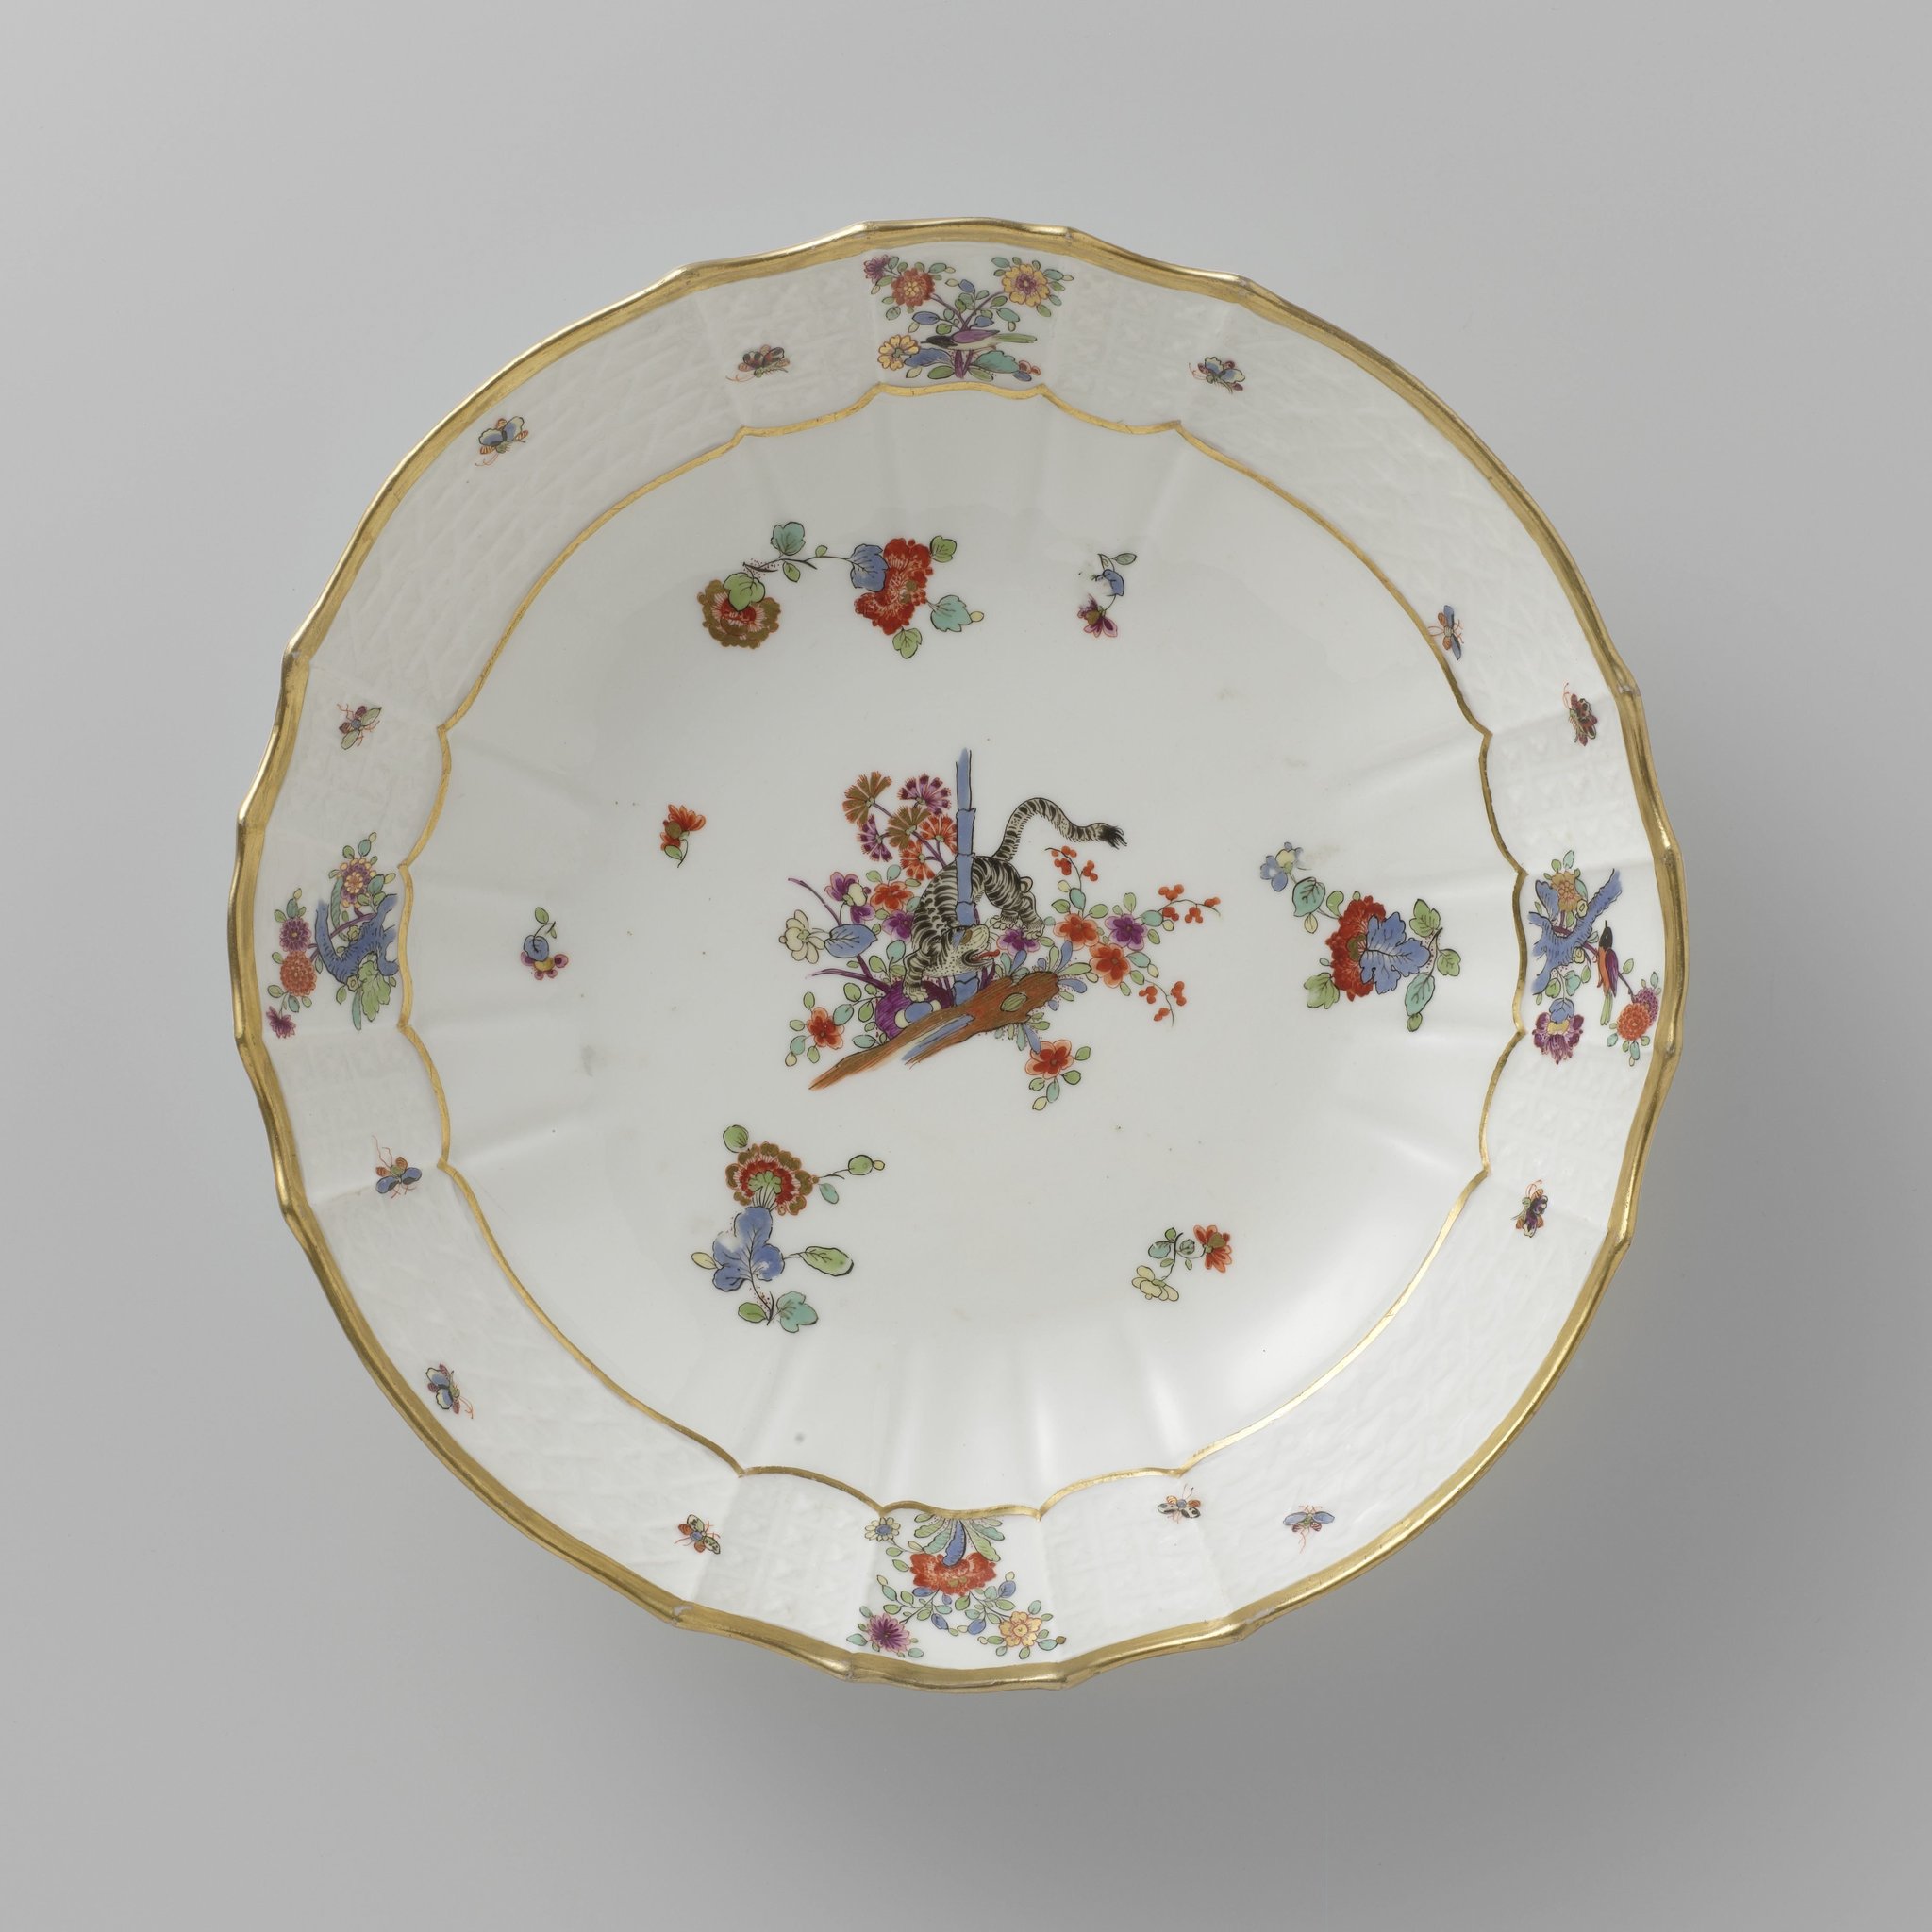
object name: platter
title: Schotel, veelkleurig beschilderd met een Kakiemon-decor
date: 1740-1745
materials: porcelain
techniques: painted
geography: meissen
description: Ronde schotel van beschilderd porselein. De schotel heeft een geribde en geschulpte rand. De schotel is beschilderd met een tijger om een bamboestengel, gestrooide Indianische Blumen, vlinders en takken met vogels. De rand is versierd met het 'Altbrandenstein'-patroon. De schotel is gemerkt.